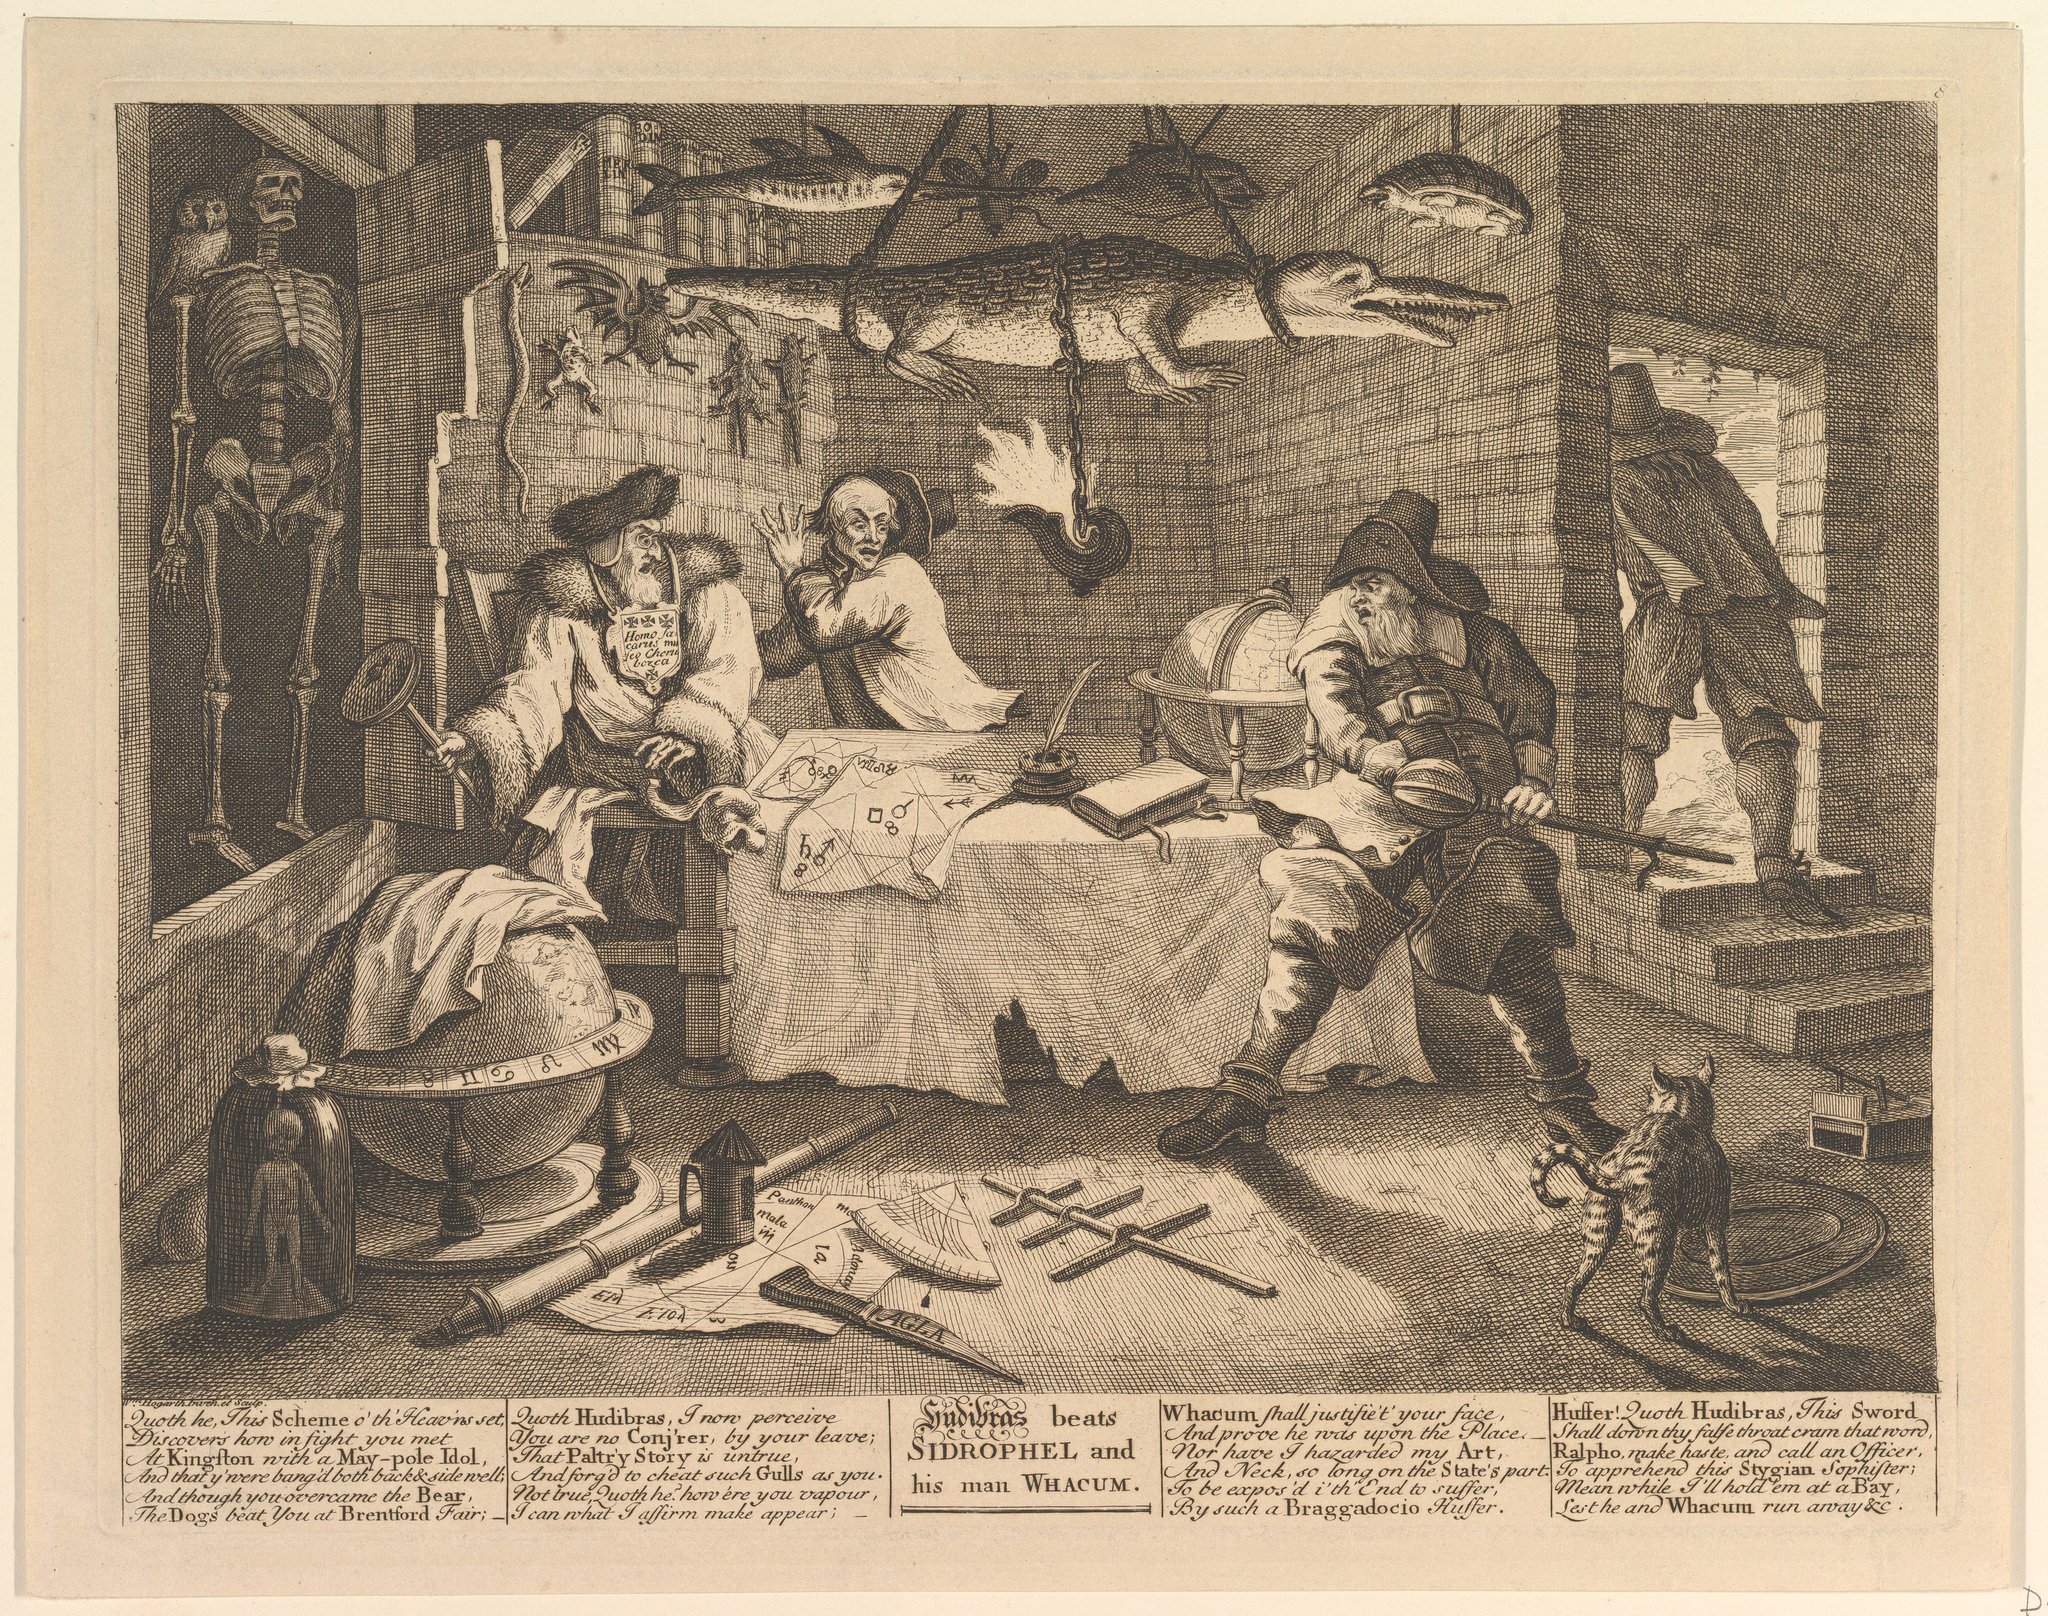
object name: print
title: Hudibras beats Sidrophel and his man Whacum (Twelve Large Illustrations for Samuel Butler's Hudibras, Plate 8)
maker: william hogarth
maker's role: artist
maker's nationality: british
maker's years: 1697-1764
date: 1725-1768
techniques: engraving, etching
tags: bats,skeletons,fear,men,owls,cats,crocodiles,scientists